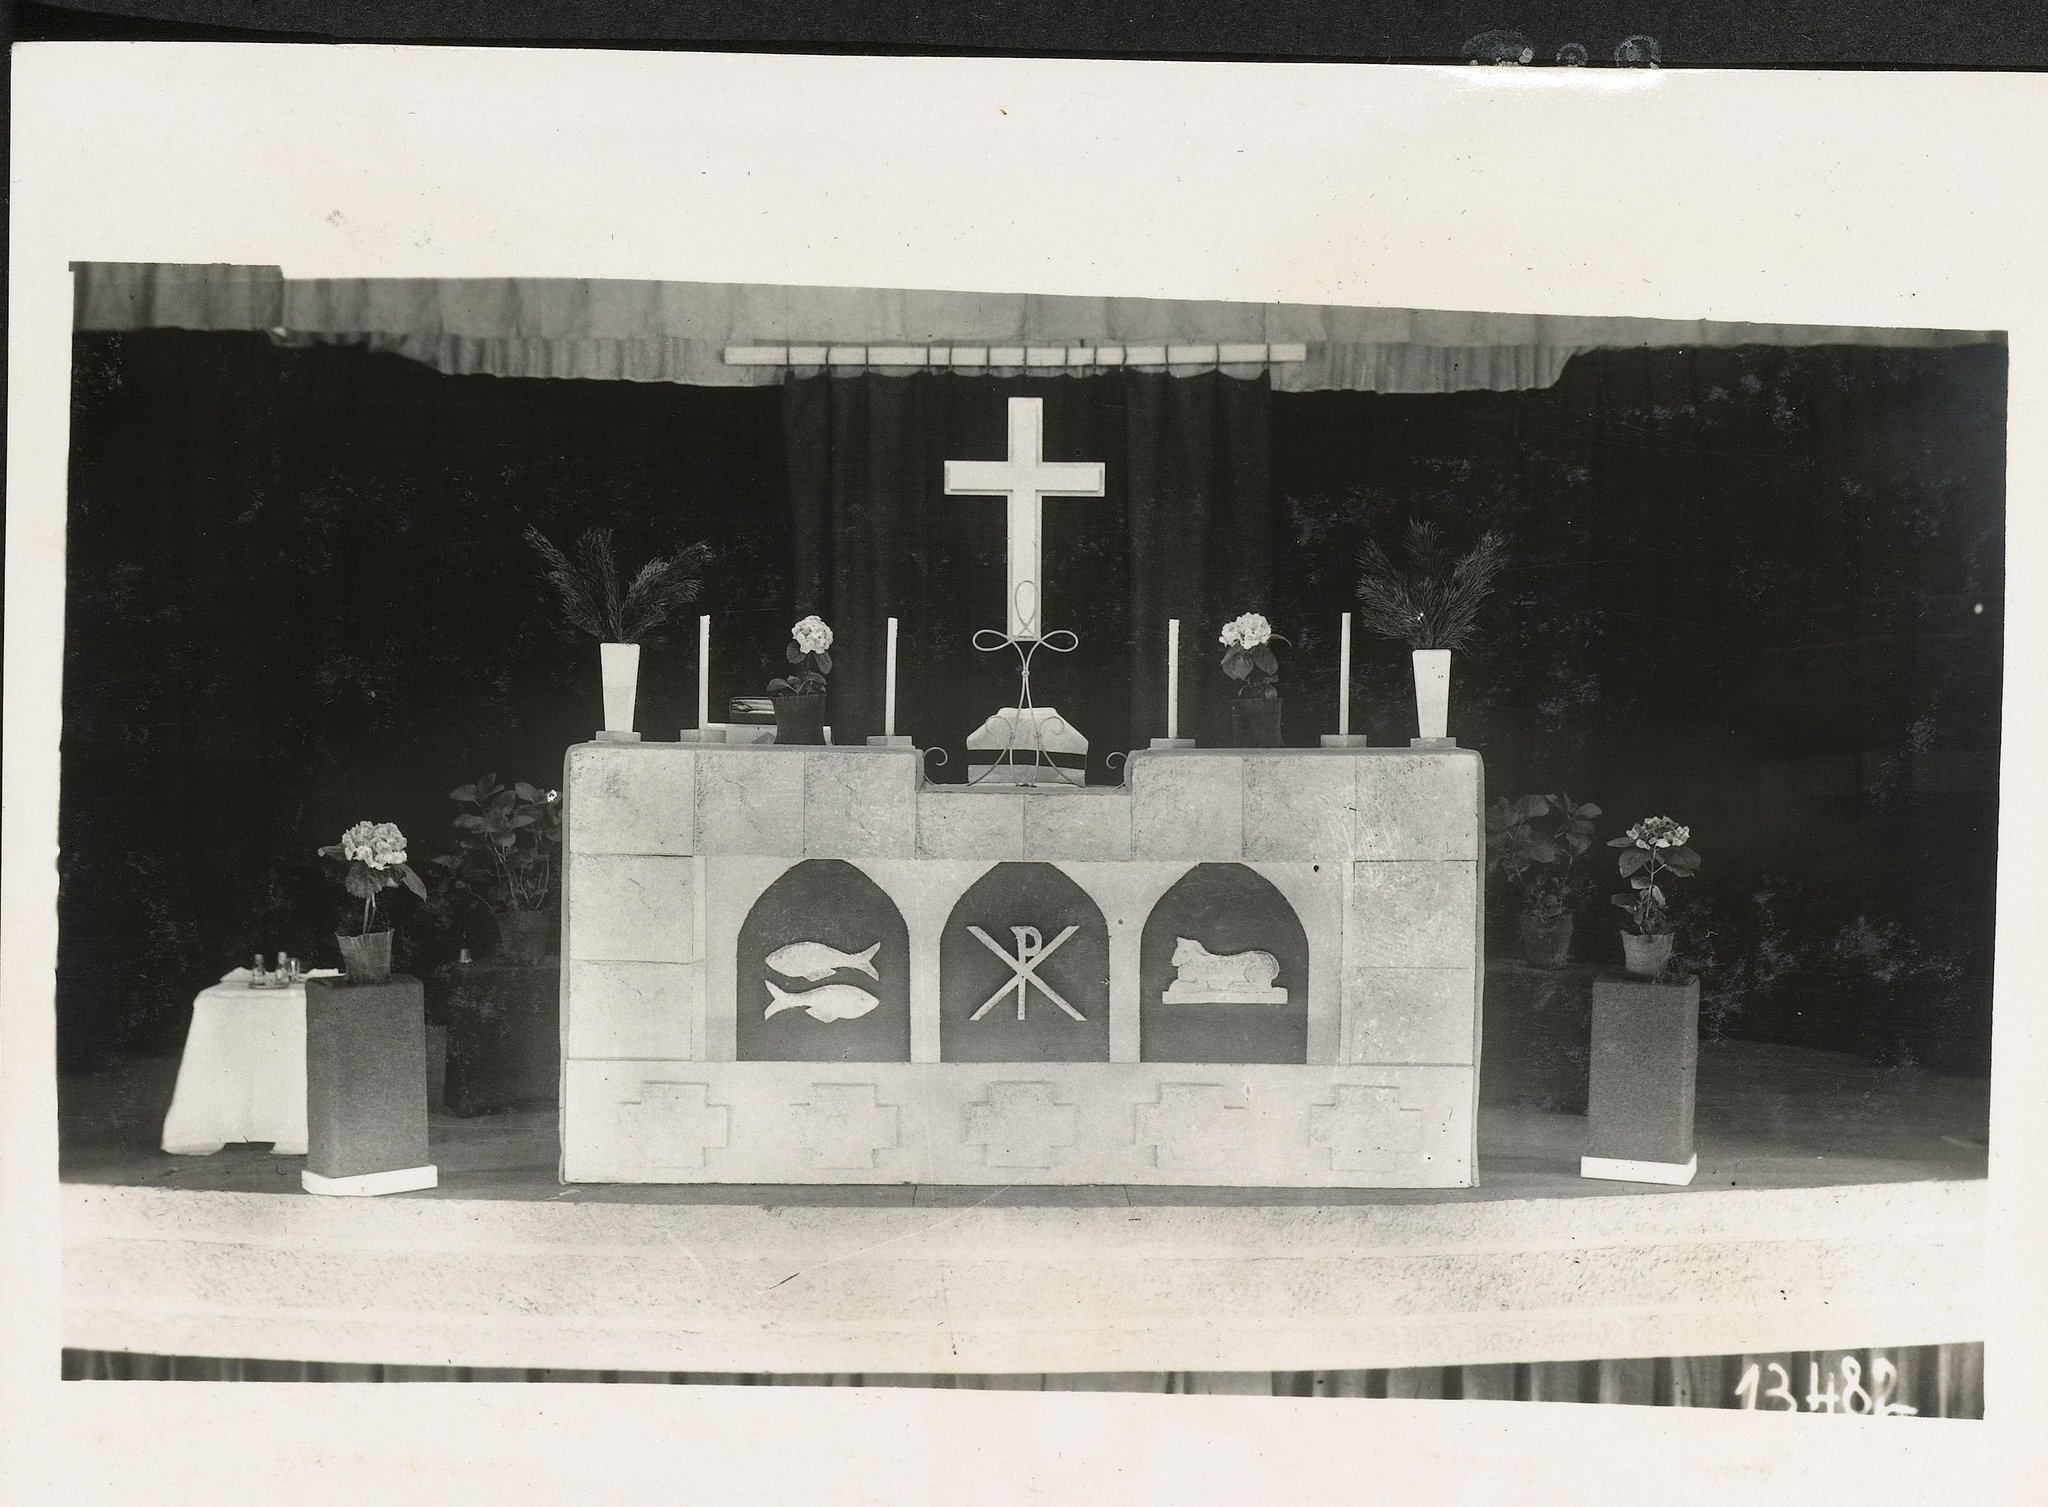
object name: photograph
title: Herdenking sterfdag Roosevelt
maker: dick w.b. van maarseveen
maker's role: fotograaf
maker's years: 1905-1990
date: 1943-1945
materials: cardboard, photographic support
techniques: gelatin silver print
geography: muhlberg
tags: dick w.b. van maarseveen, new york (city)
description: Albumblad met twee foto's: bijeenkomst van alle gevangenen bij het overlijden van de Amerikaanse president Roosevelt op 12 april 1945 en een altaar voor de mis. Onderdeel van een fotoalbum met foto's door Dick van Maarseveen van het krijgsgevangenenkamp Stalag IV B in Mühlberg in de periode 1943-1945.